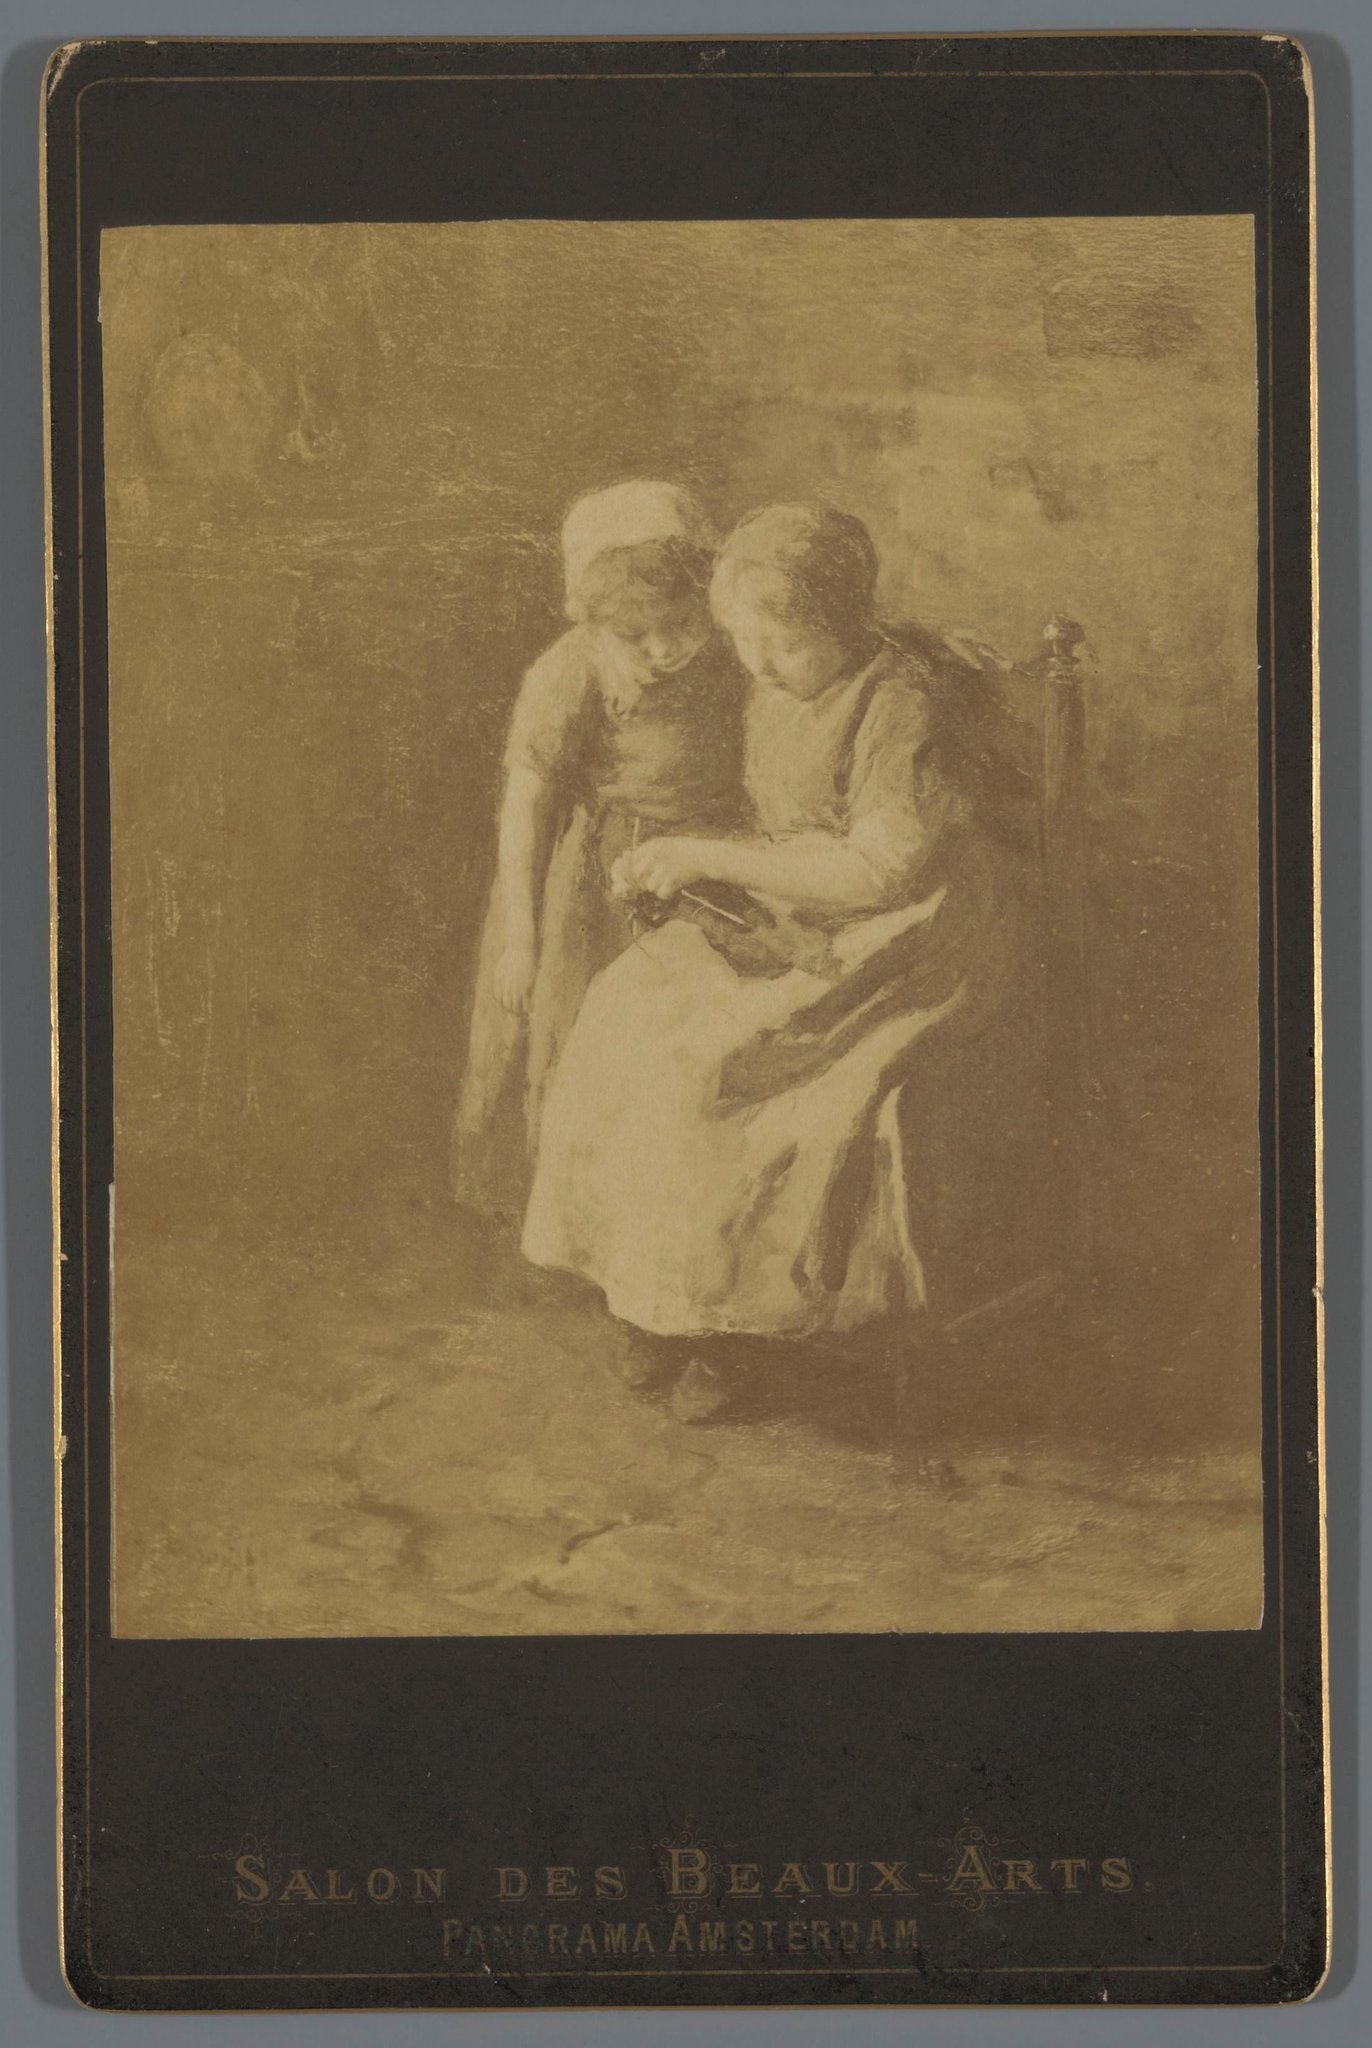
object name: reproduction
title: Fotoreproductie van schilderij Twee zusjes door Albert Neuhuys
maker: Anonymous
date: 1850-1900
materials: cardboard, photographic support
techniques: albumen print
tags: child, knitting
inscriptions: inscription: ‘Salon des Beaux-Arts./ Panorama Amsterdam’, inscription: ‘Alb. Neuhuijs. Twee Zusjes’